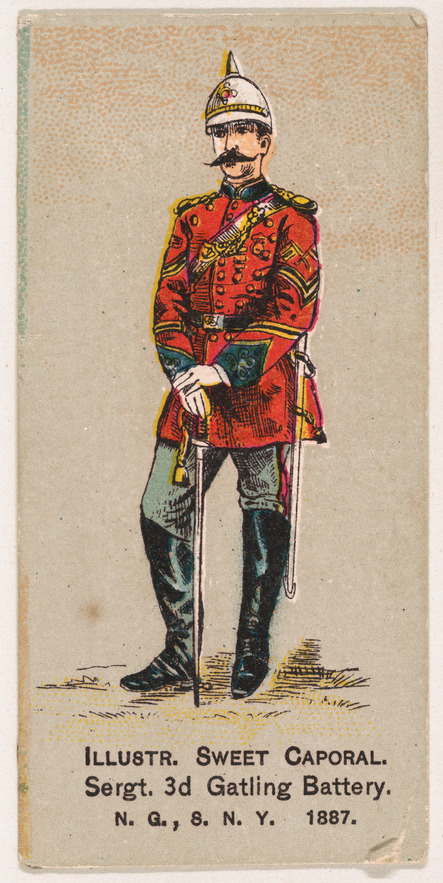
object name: print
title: Sergeant, 3rd Gatling Battery, National Guard of the State of New York, from the Military Series (N224) issued by Kinney Tobacco Company to promote Sweet Caporal Cigarettes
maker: kinney brothers tobacco company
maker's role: publisher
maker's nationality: american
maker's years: 1869-2011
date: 1888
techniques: color lithograph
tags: soldiers,swords,men